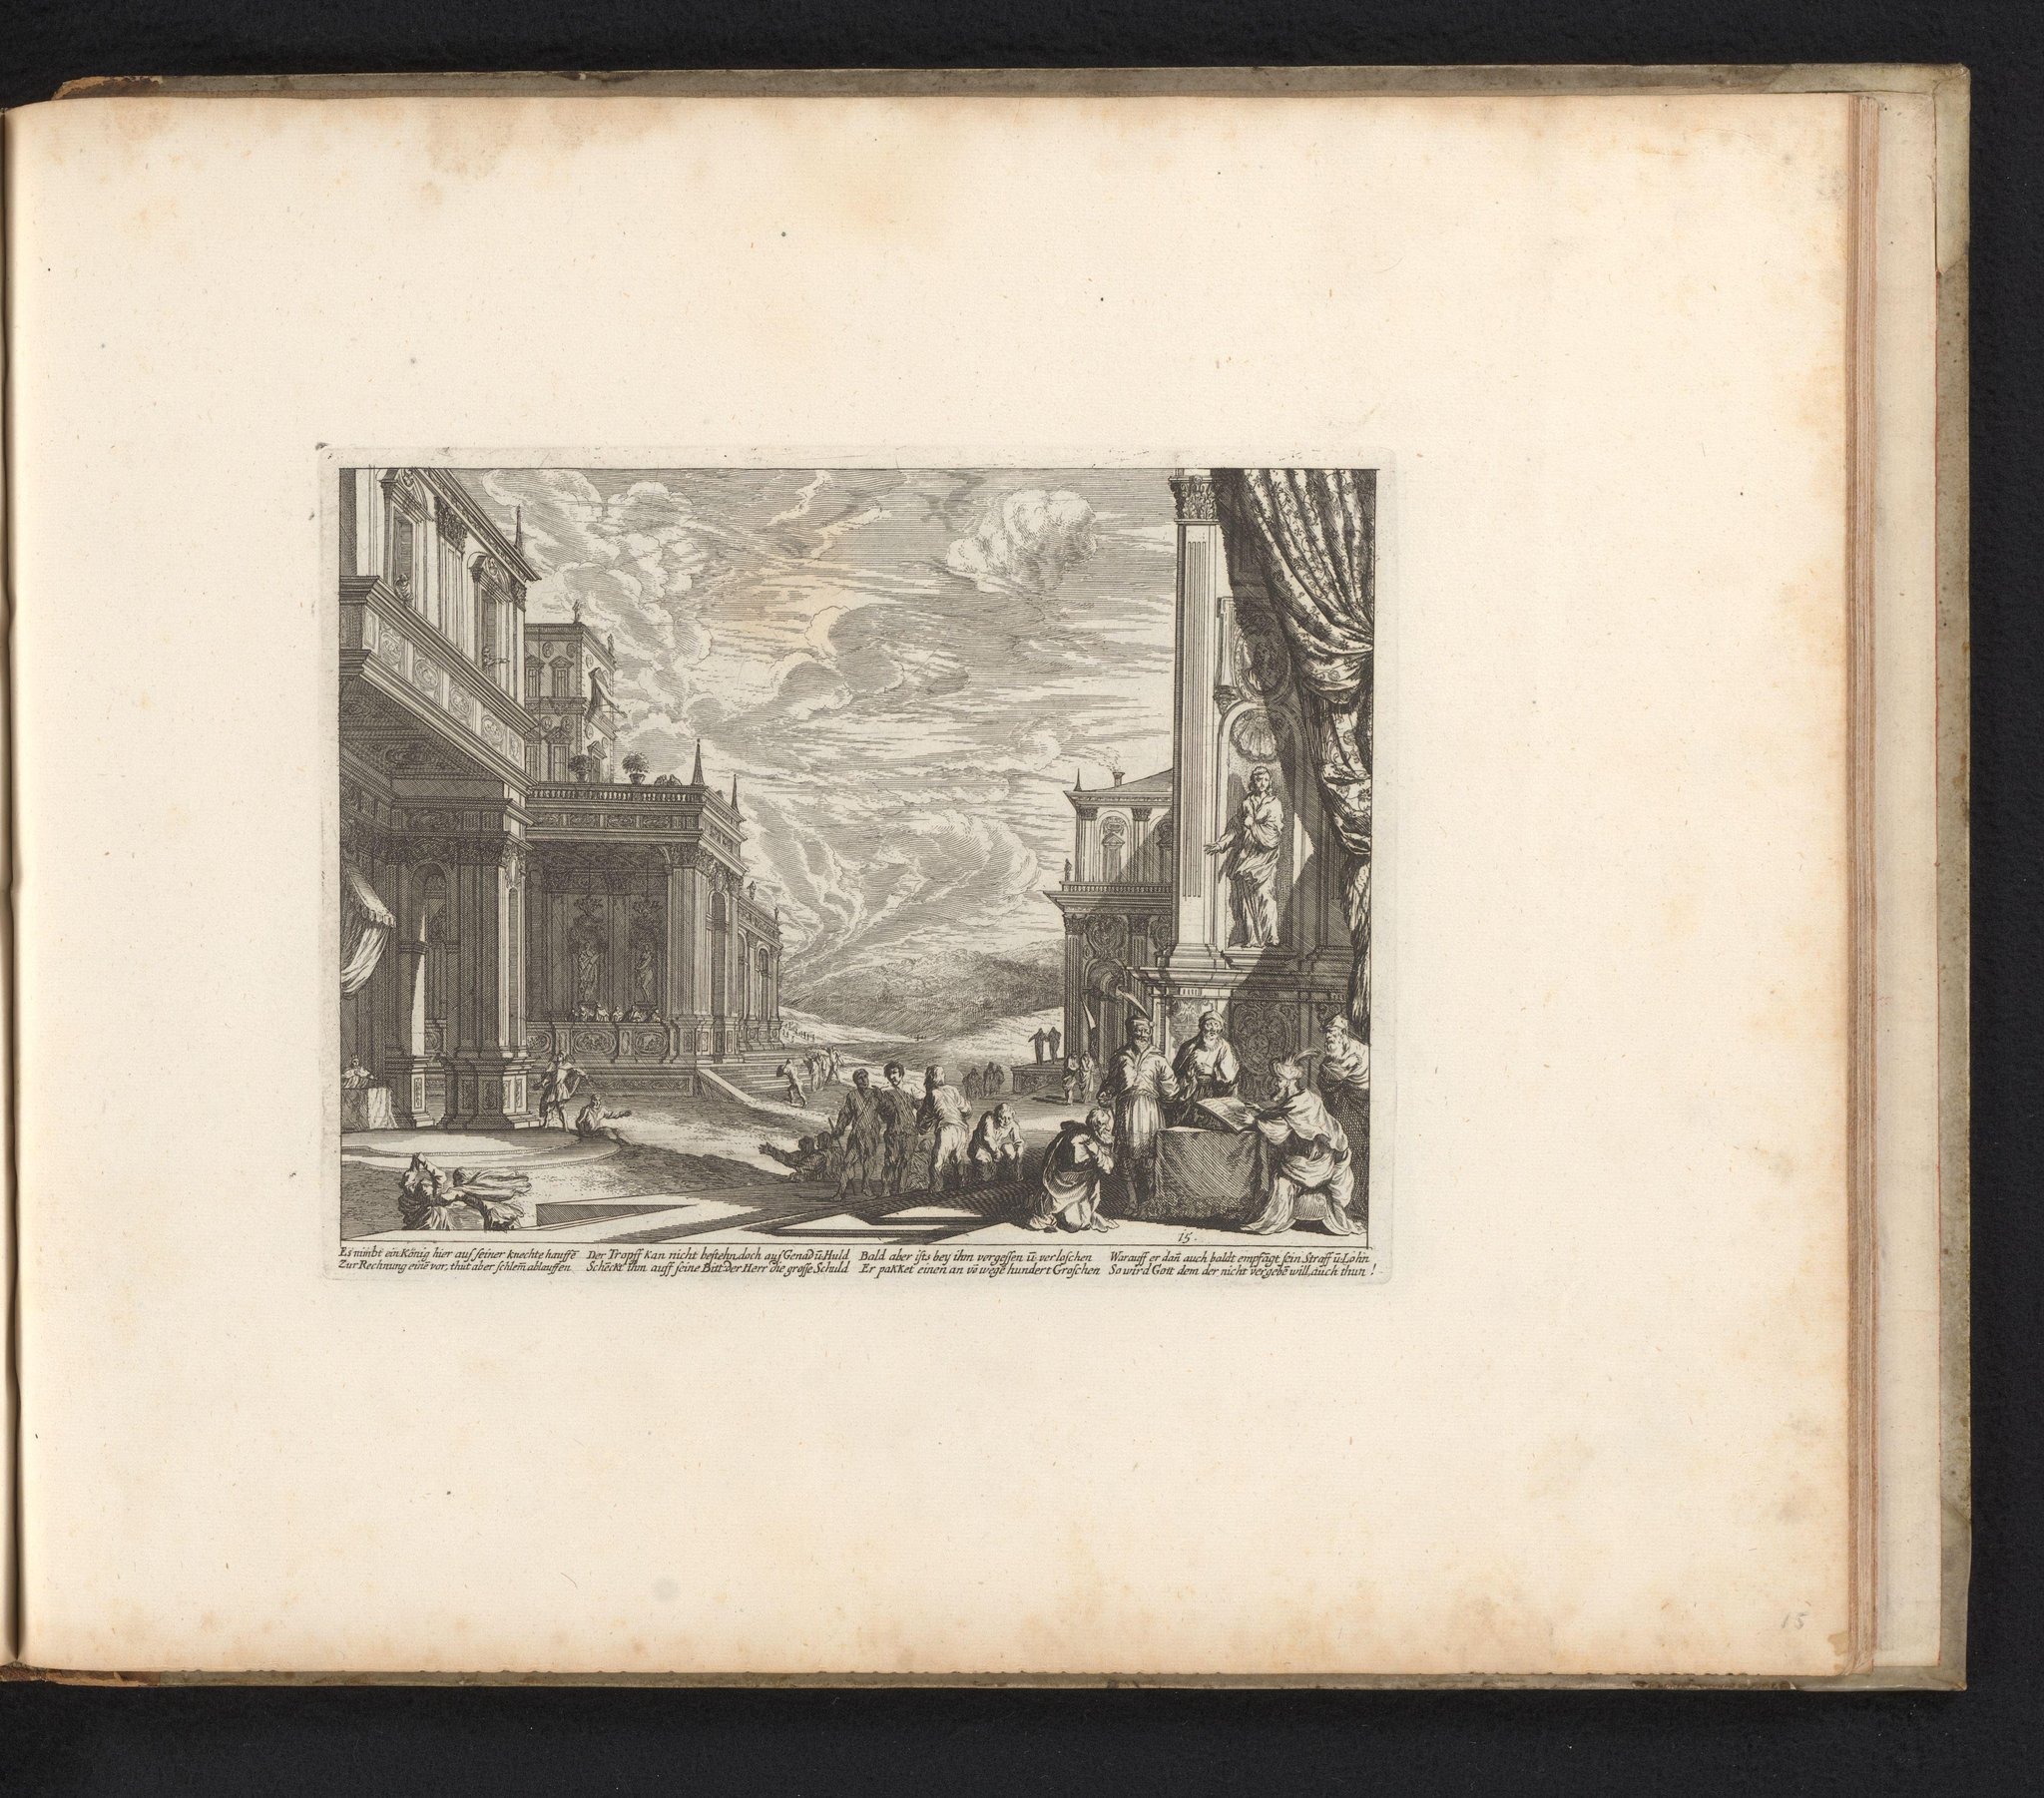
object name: album leaf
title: Herodes voor het gerecht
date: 1670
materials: paper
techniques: etching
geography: augsburg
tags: christ before king herod; sometimes a gorgeous robe is brought (luke 23:8-11)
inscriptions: collector's mark: Lugt 2228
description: Tekst in het Duits in de ondermarge. Rechtsonder genummerd: 15. Prent maakt deel uit van een album.